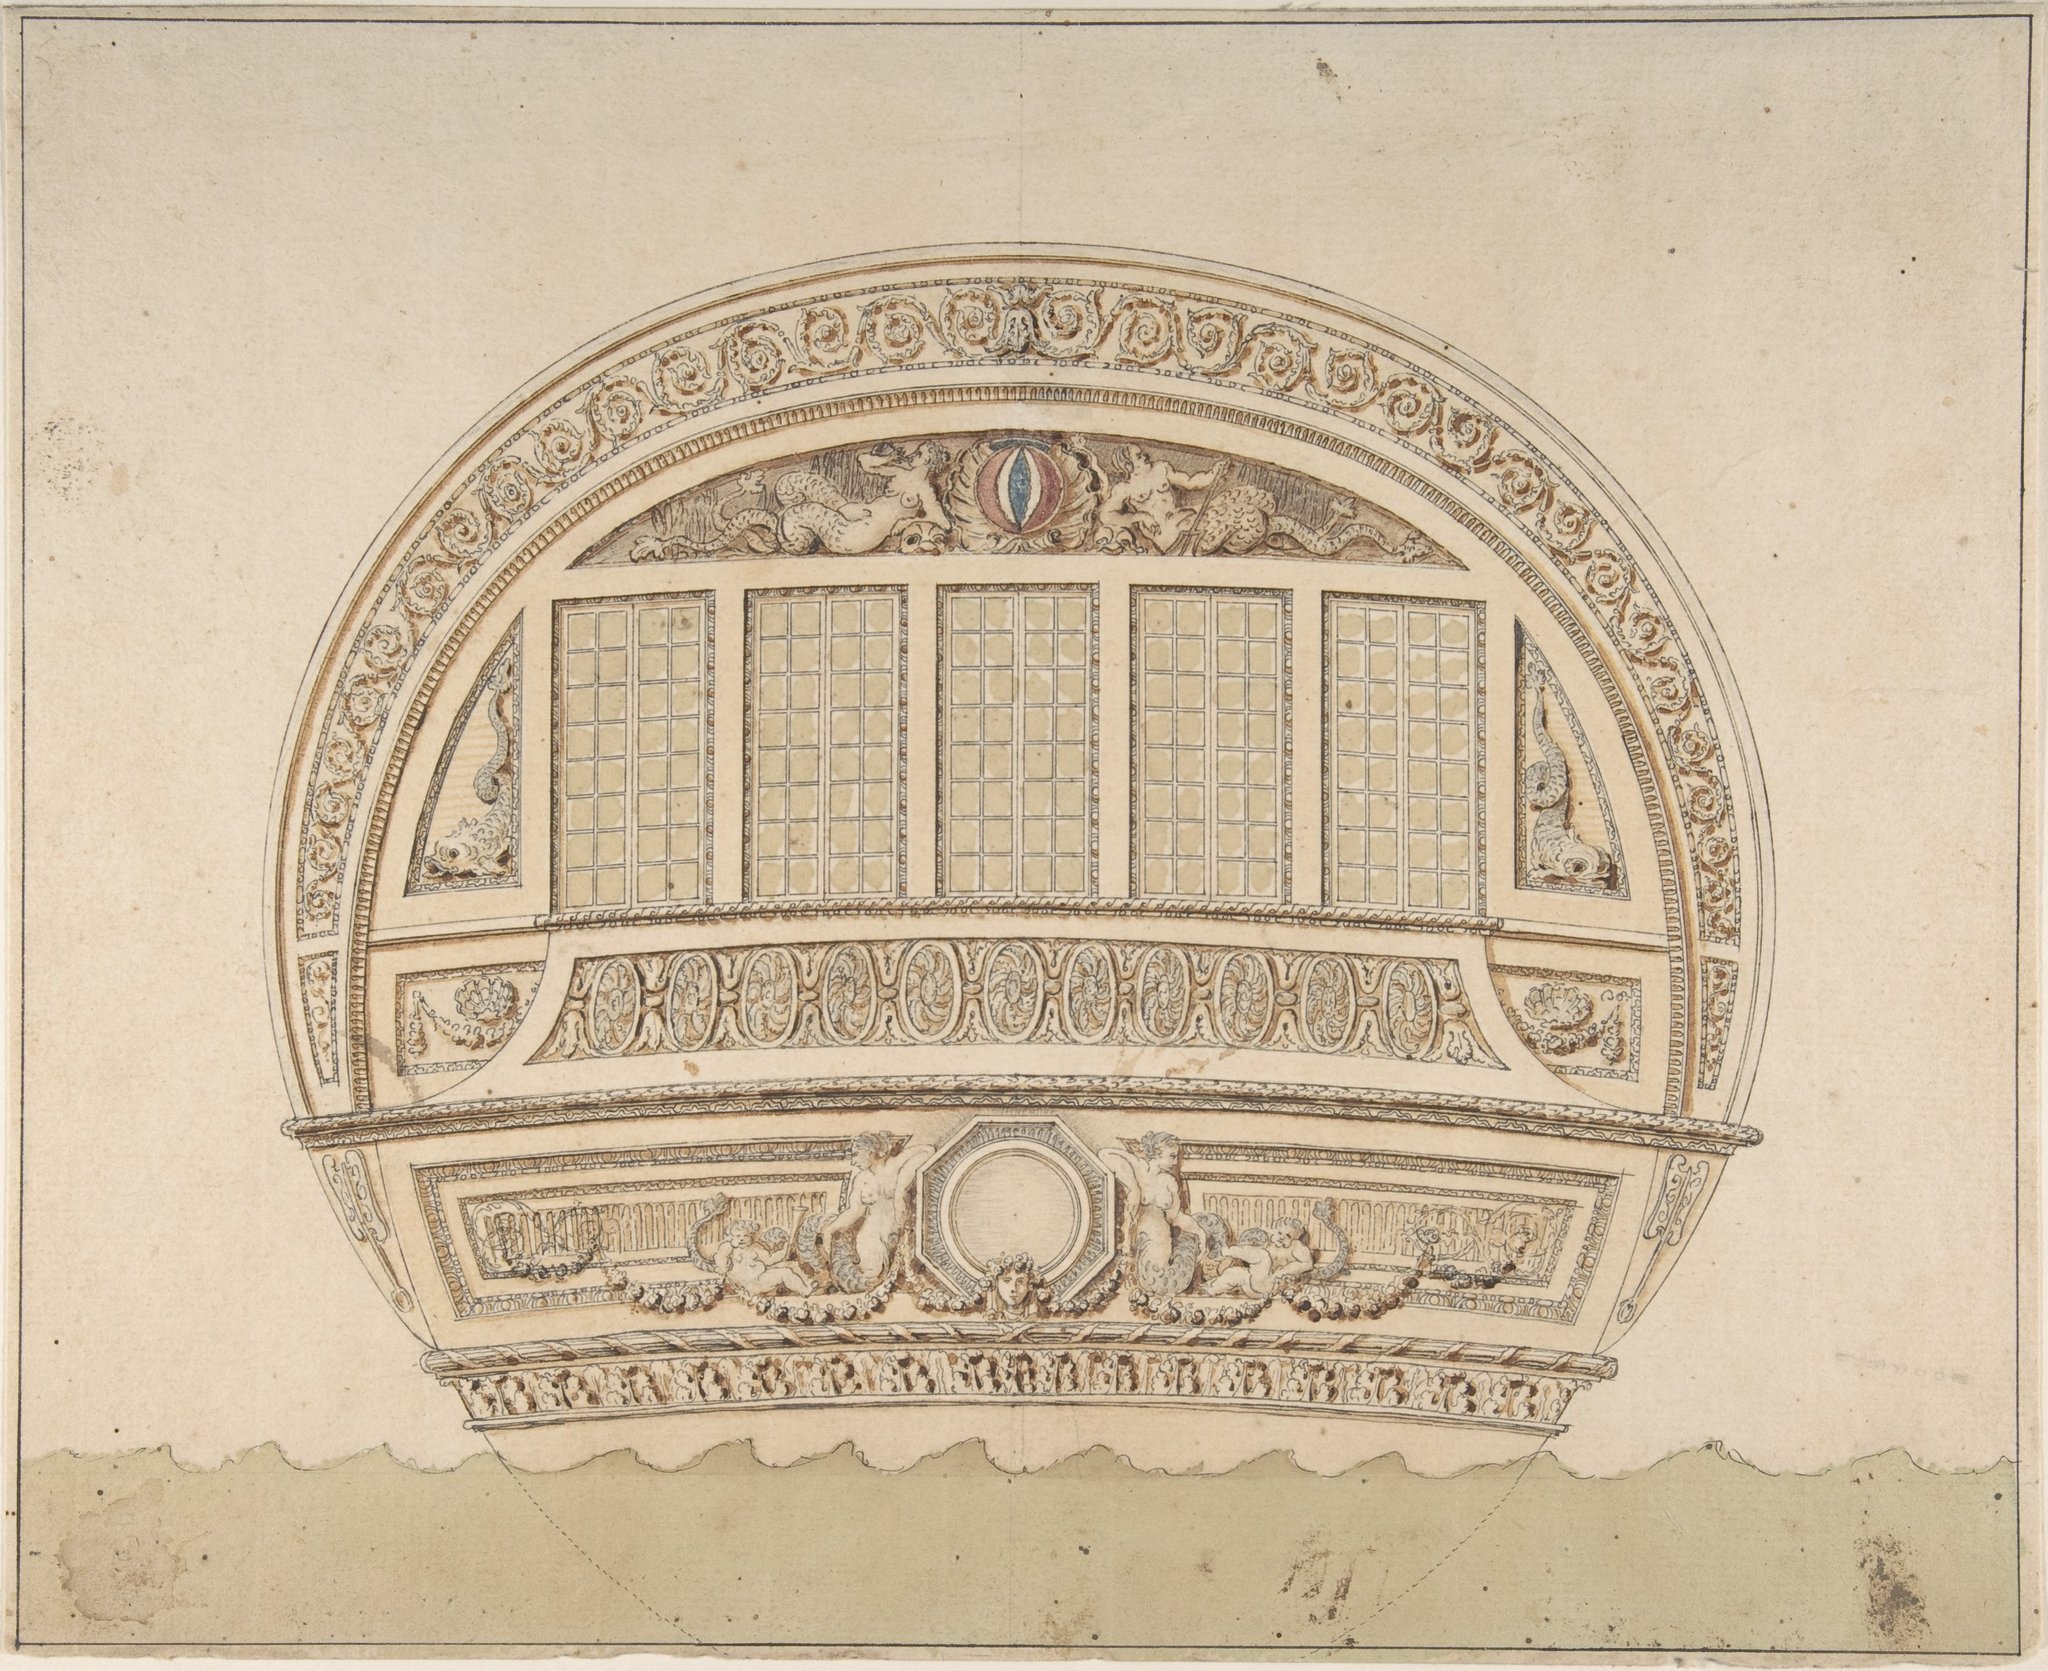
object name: drawing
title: Design for Stem of a Ship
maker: anonymous, french, 18th century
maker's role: artist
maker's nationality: french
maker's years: 1700-1800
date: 1701-1800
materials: graphite, ink, watercolor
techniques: brush, pen, wash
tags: mythical creatures,ships